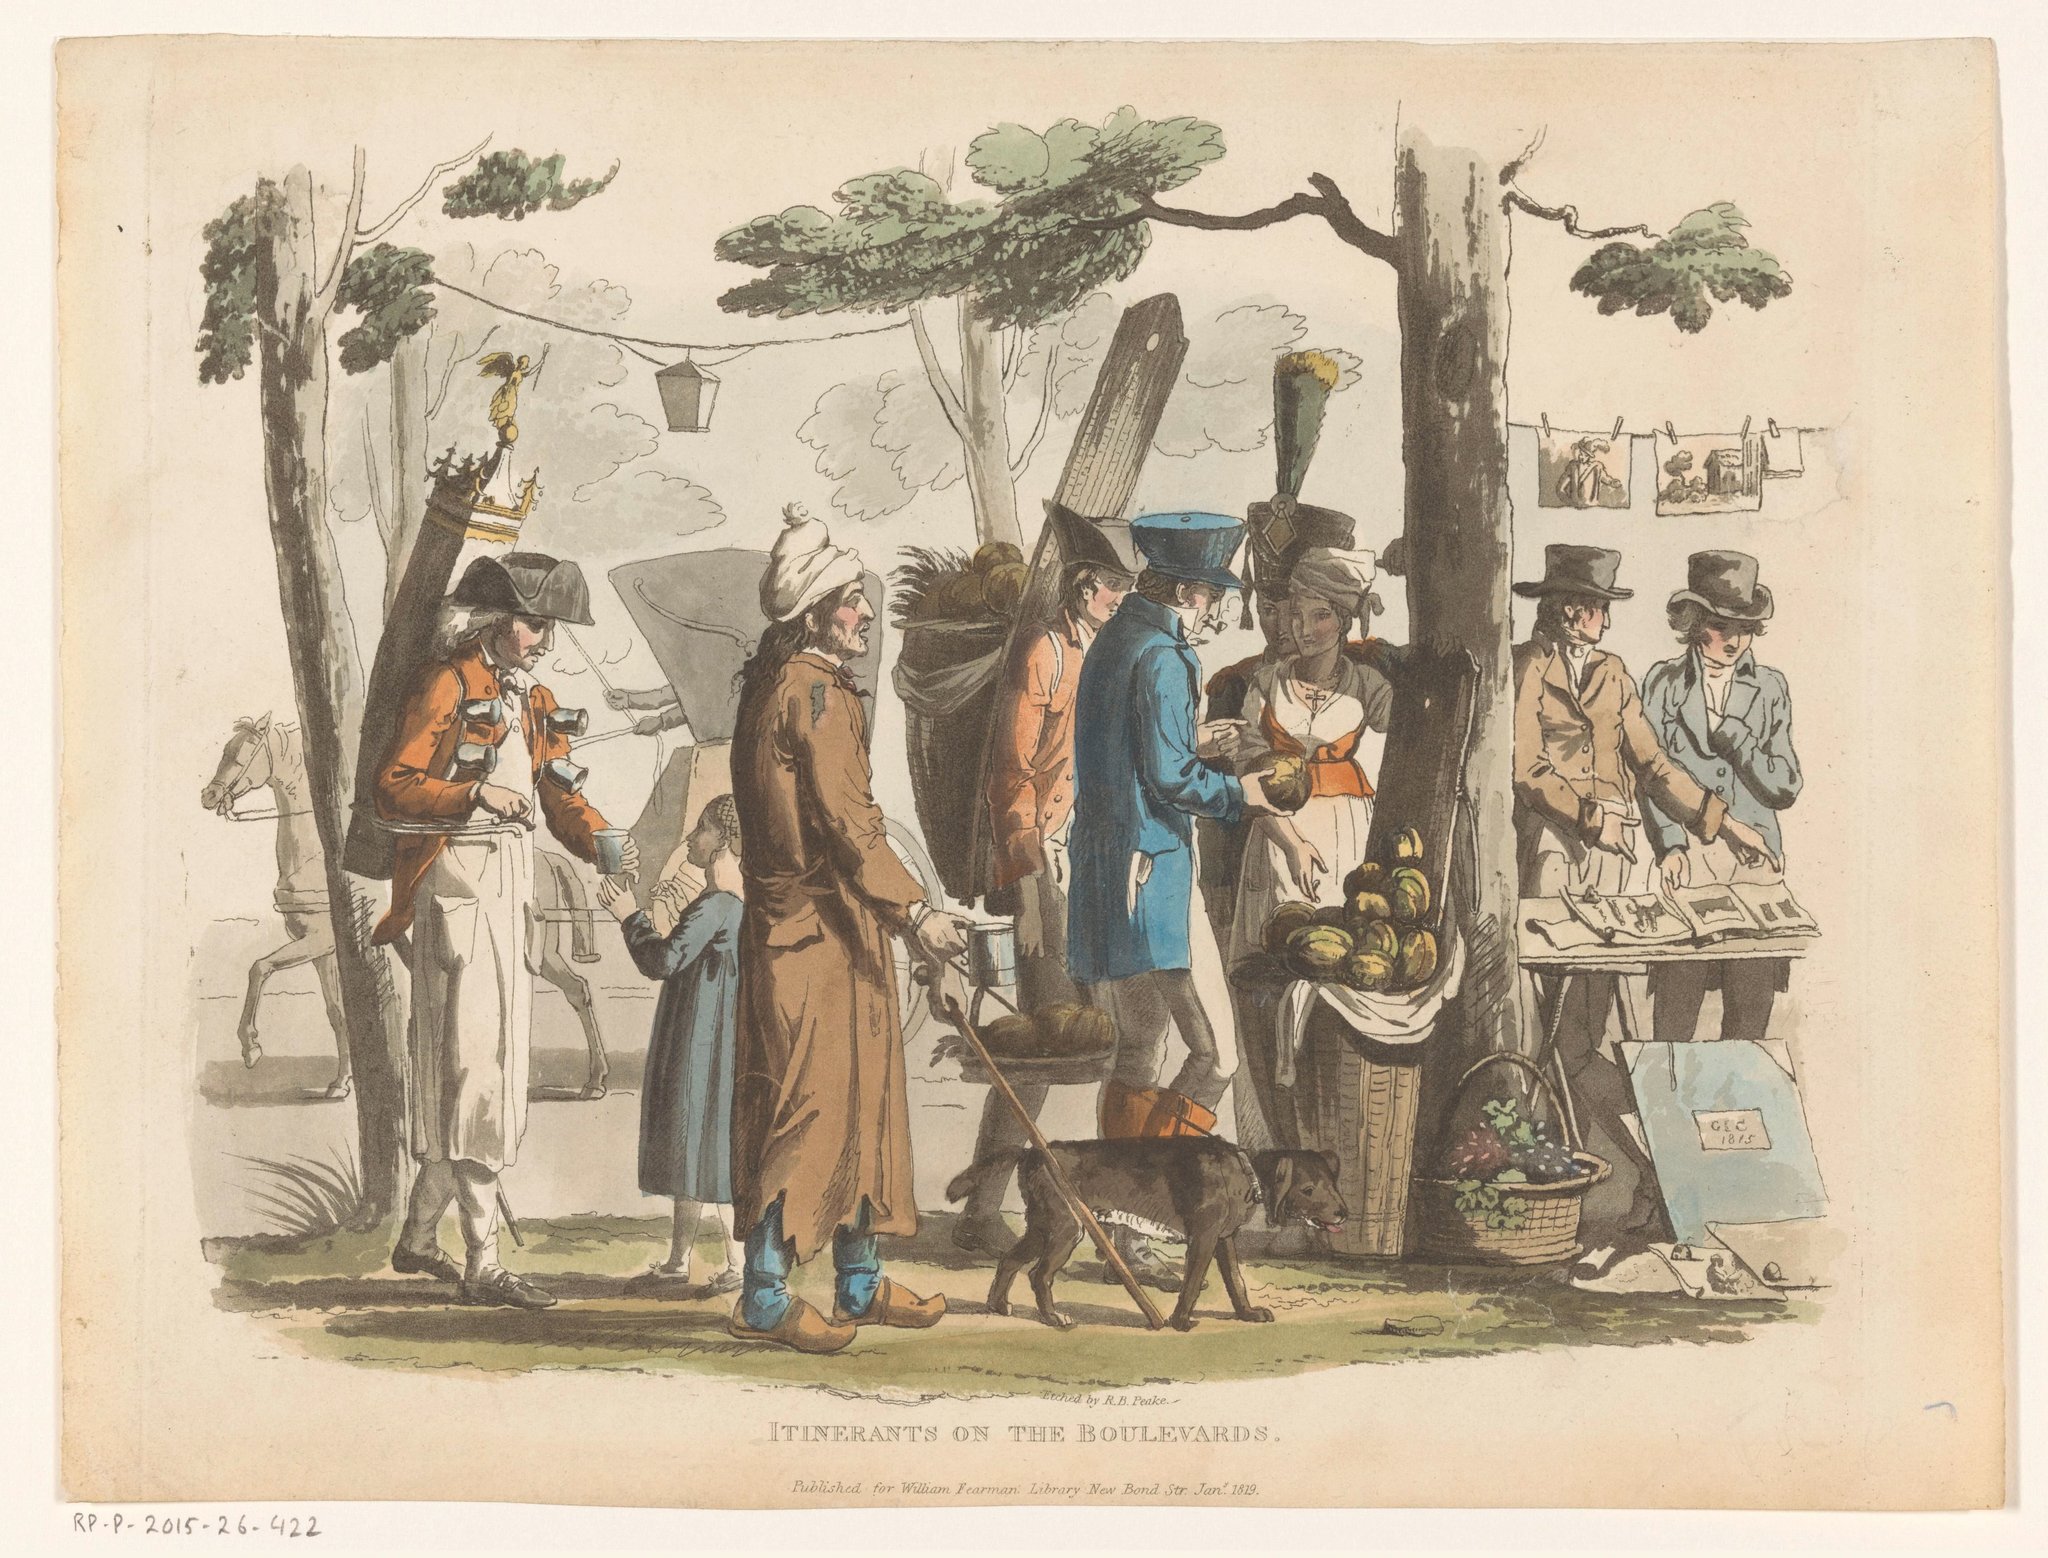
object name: book illustration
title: Straatscène met kooplieden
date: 1815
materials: paper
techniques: aquatint, etching, hand coloring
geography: london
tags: chocolate, cocoa, private soldier, print, e.g.: engraving, etching, lithograph, street-trader, merchant, salesman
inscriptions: collector's mark: Lugt 2228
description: Straatscène met onder anderen een verkoper van chocolademelk, een blinde bedelaar met stok en hond, een fruitverkoopster en een prenthandelaar. In de achtergrond een soldaat en een paardenkoets.